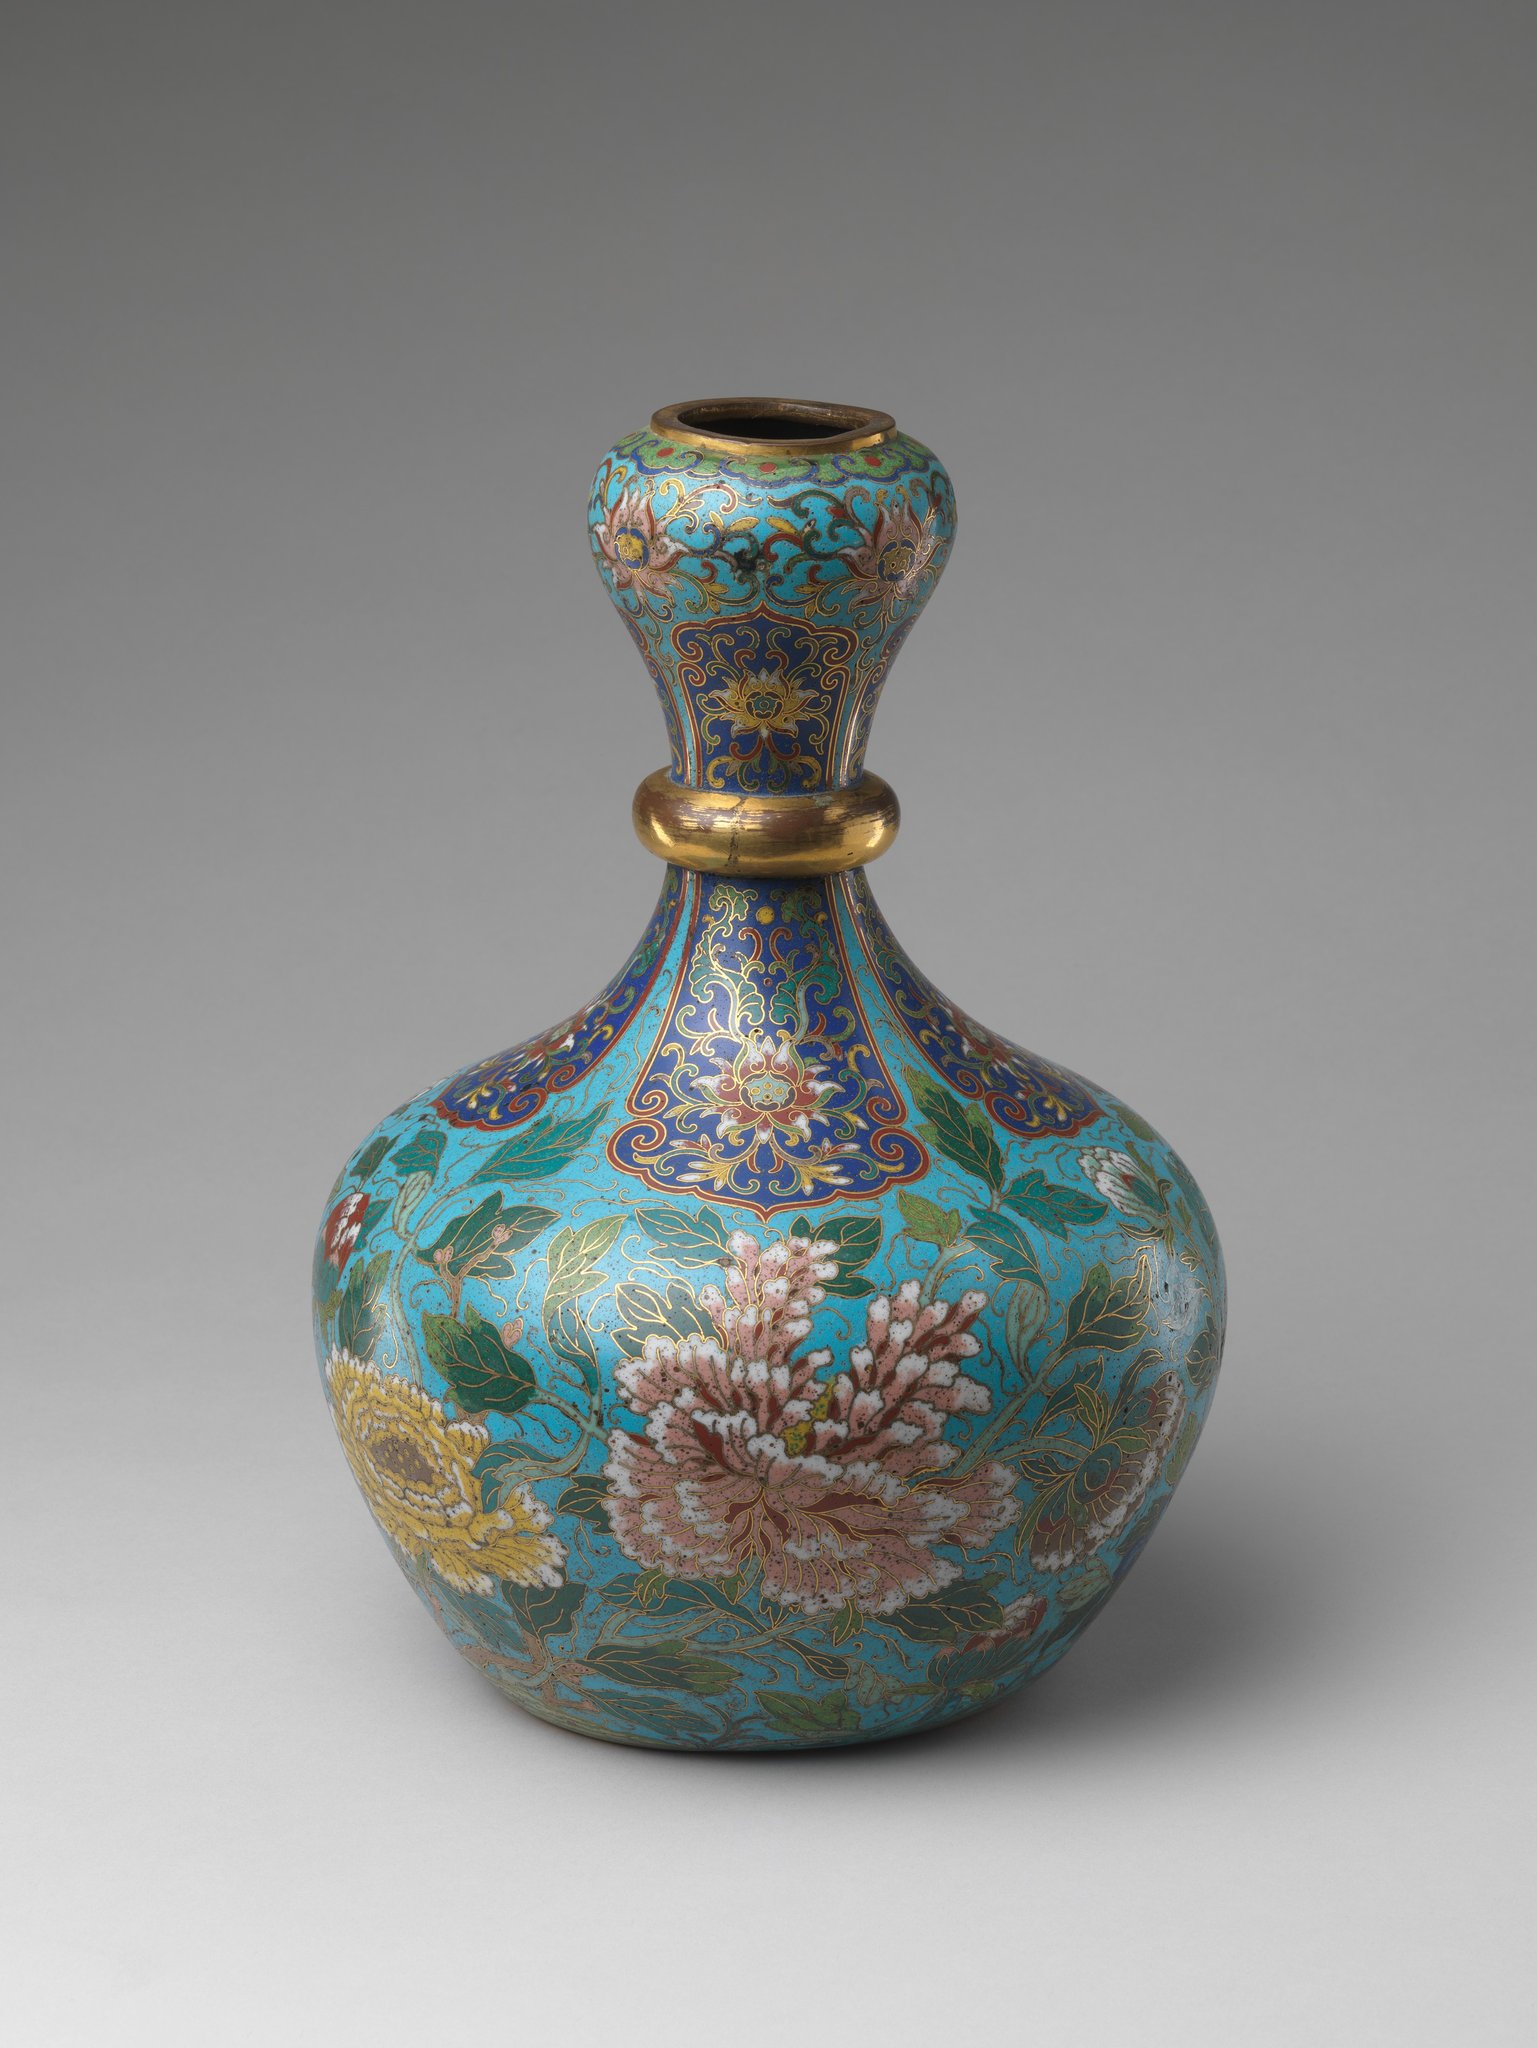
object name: vase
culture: chinese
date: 1701-1800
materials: enamel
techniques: enamel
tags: flowers,leaves